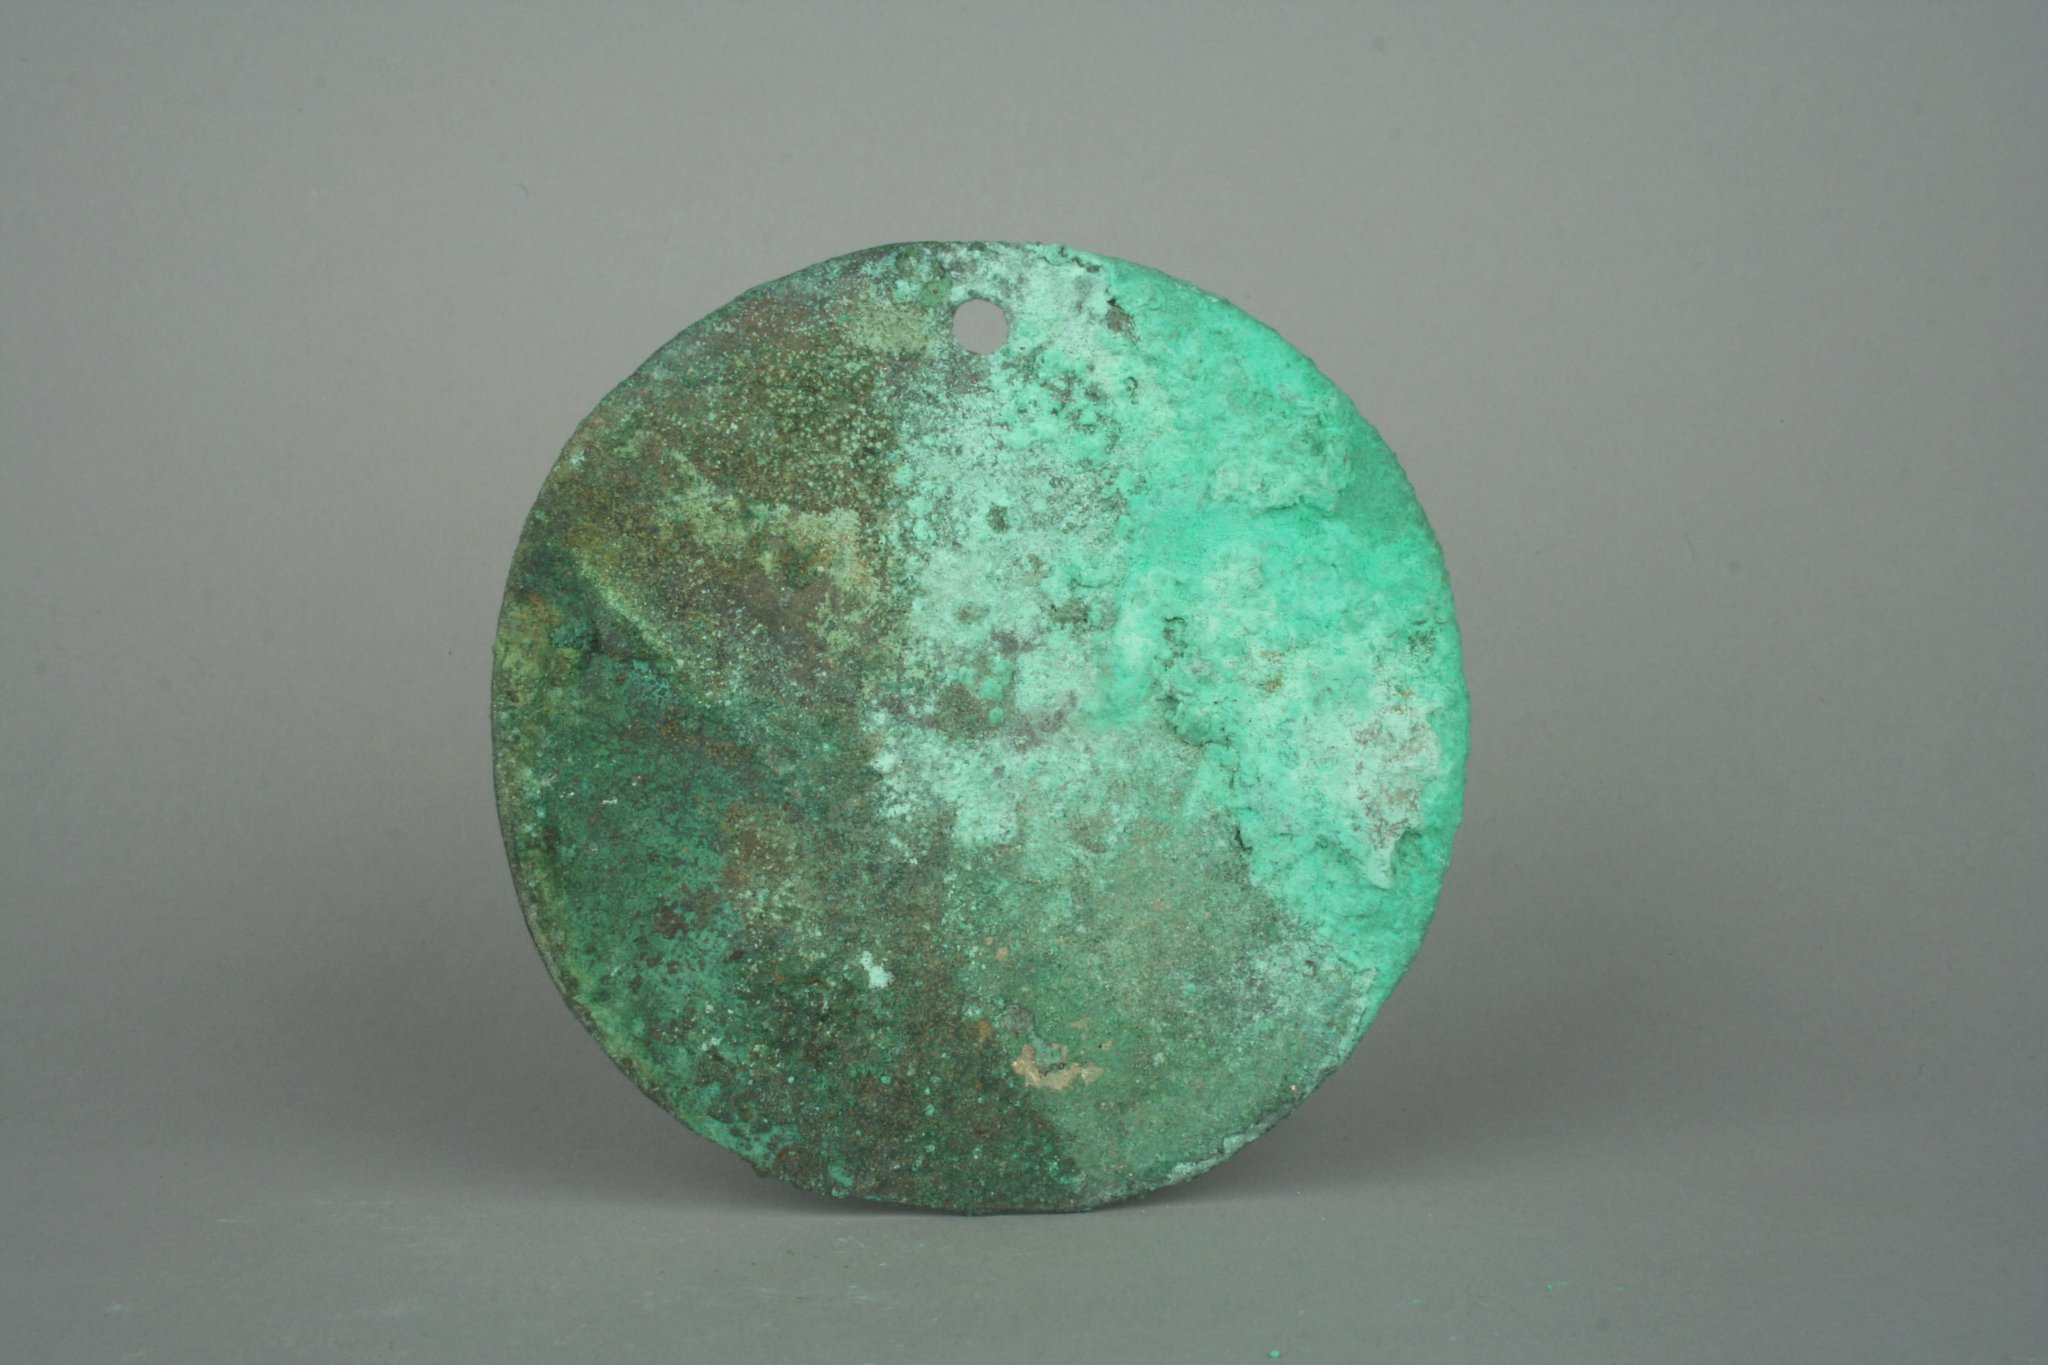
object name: plaque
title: Round Plaque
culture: vicús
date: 300 BCE-200 CE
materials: copper, gilt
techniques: hammering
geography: peru